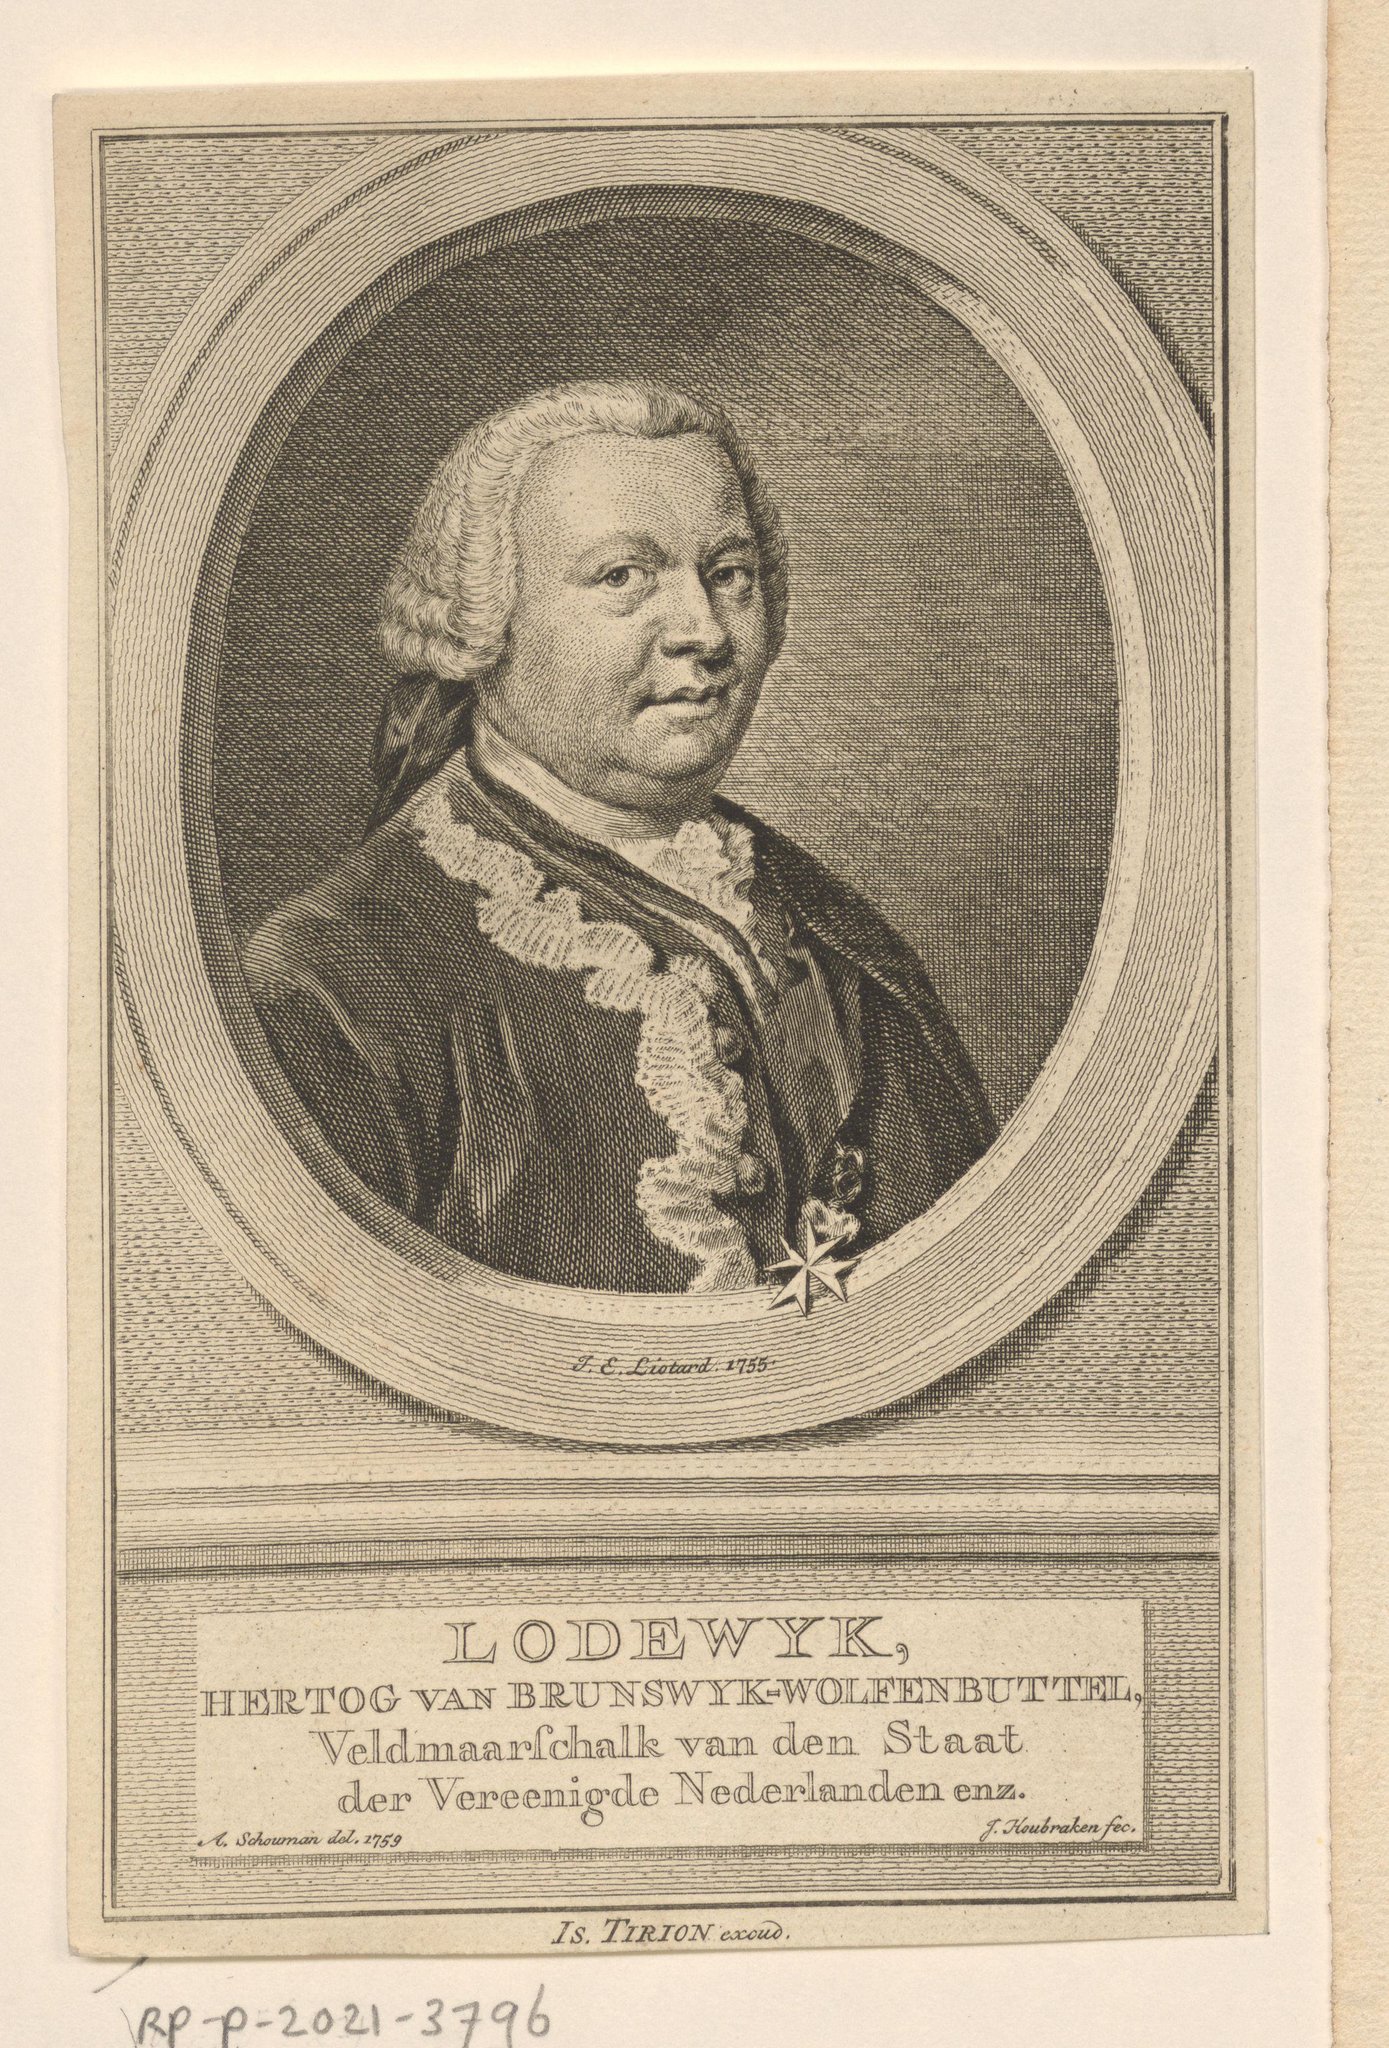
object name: print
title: Portret van Lodewijk Ernst, hertog van Brunswijk-Wolfenbüttel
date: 1796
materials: paper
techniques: engraving, etching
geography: amsterdam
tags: ludwig ernst von braunschweig-wolfenbüttel, ornament ~ medallion, historical persons, wig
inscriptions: collector's mark: Lugt 2228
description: Prent waarschijnlijk uit: Wagenaar, Jan. Vaderlandsche historie, vervattende de geschiedenissen der nu Vereenigde Nederlanden, inzonderheid die van Holland (...). Amsterdam: Johannes Allart, 1796, dl. 20. Prent is in eerdere staten gebruikt in eerdere drukken van dit werk uit 1759, 1770 en 1782.